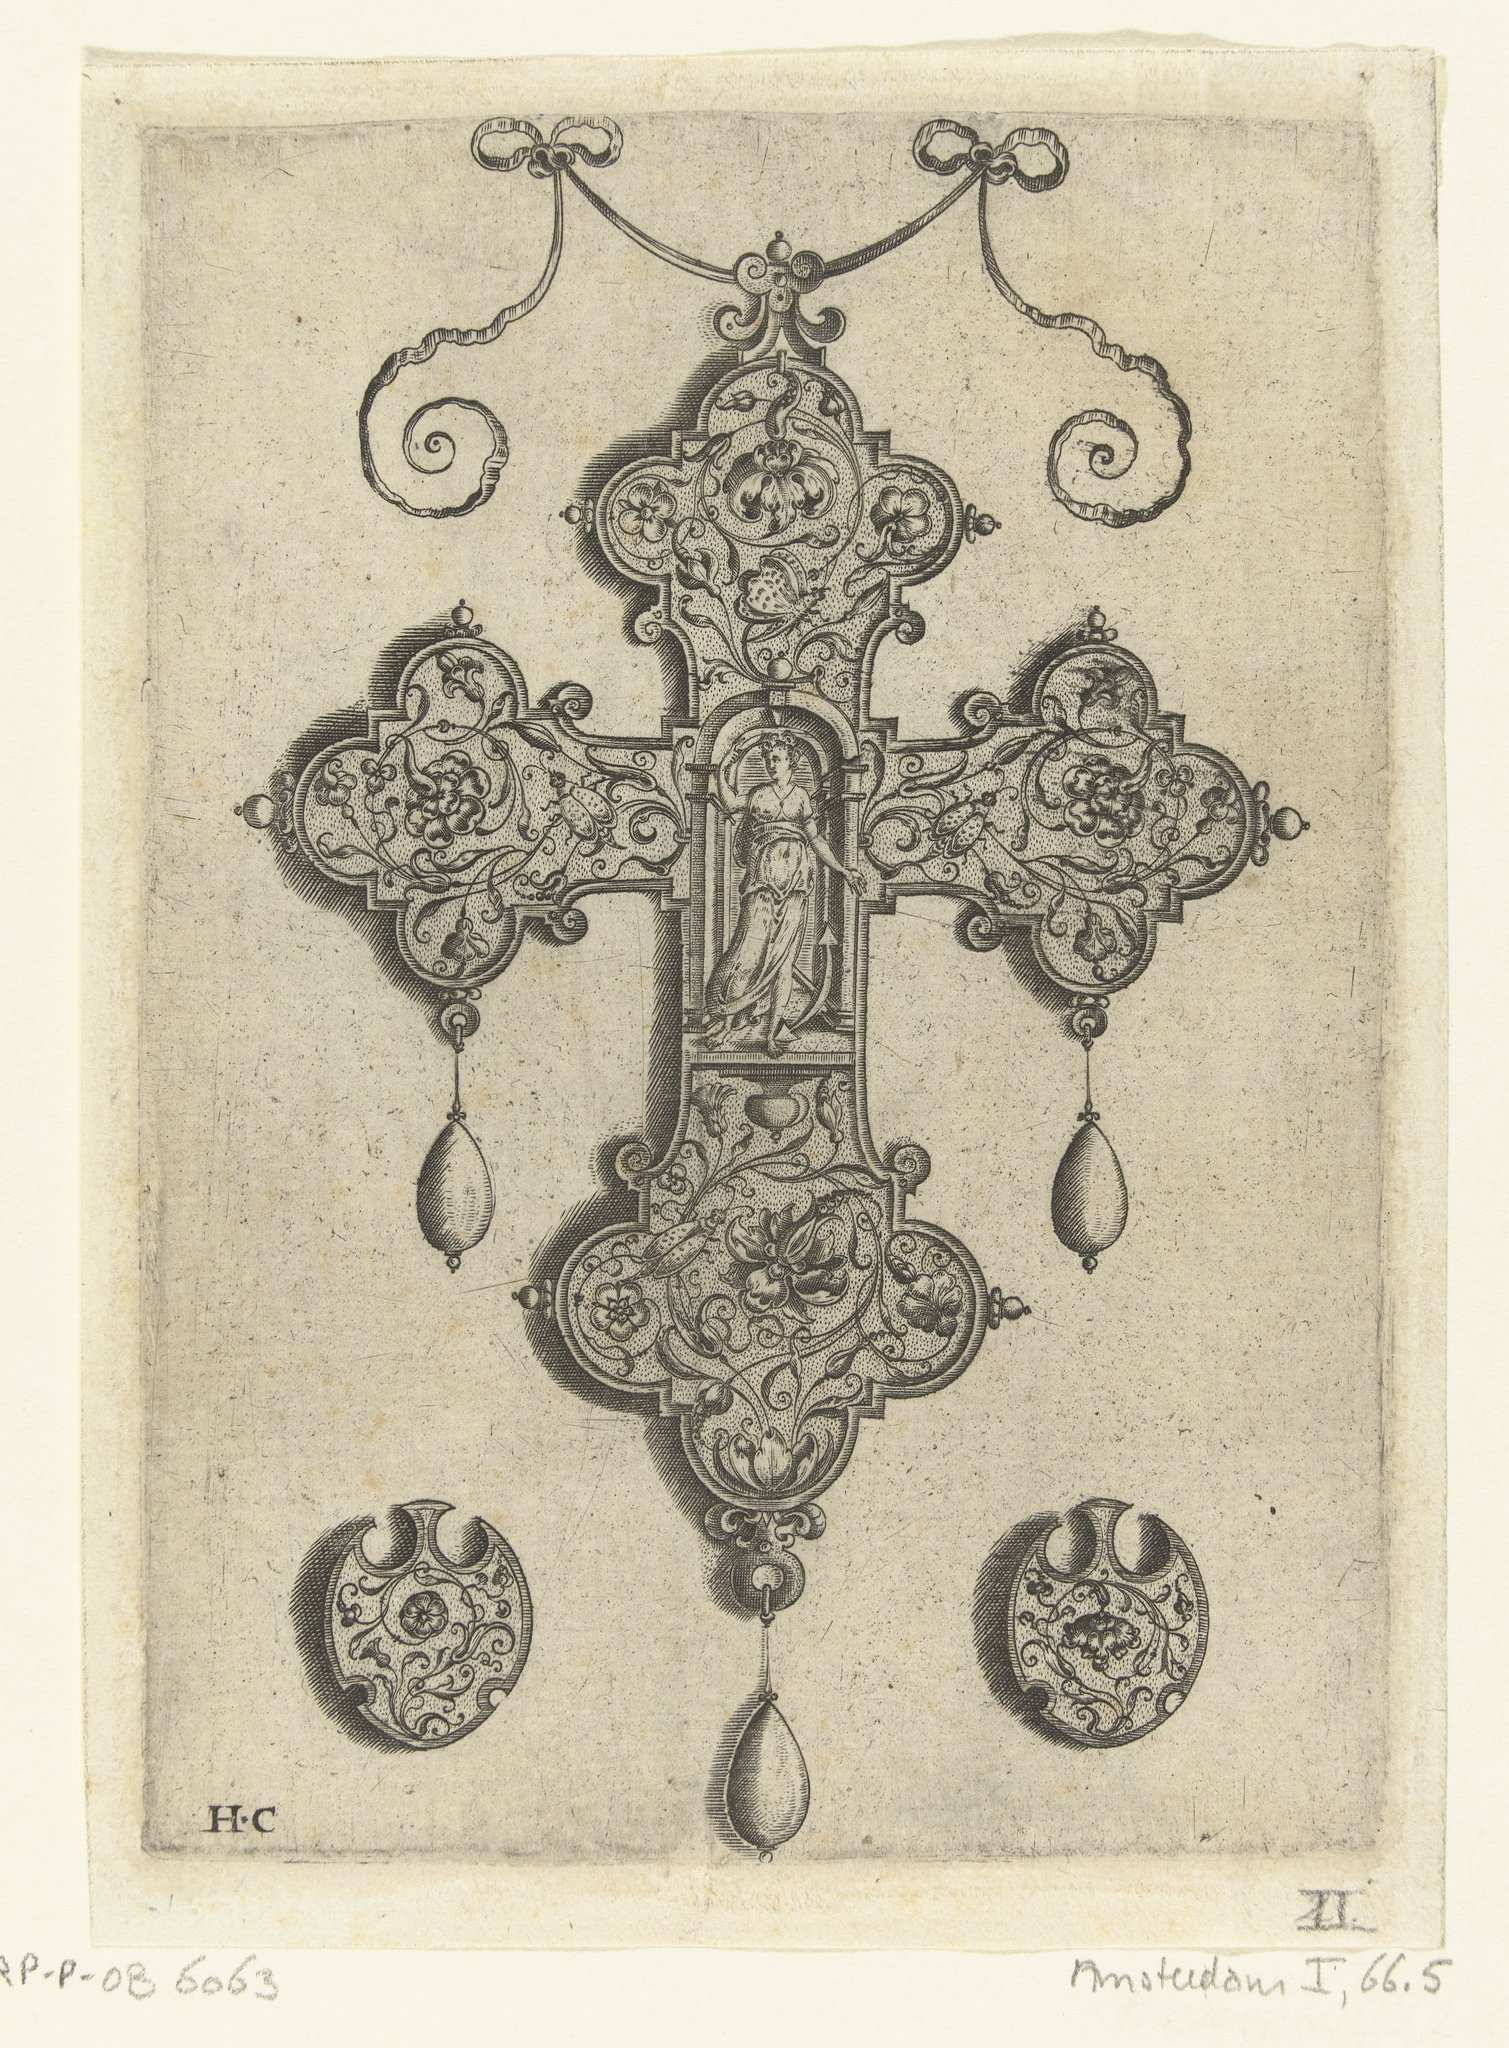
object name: print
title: Hangers met arabesken en figuren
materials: paper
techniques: engraving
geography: netherlands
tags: hope, 'spes'; 'speranza divina e certa' (ripa) ~ one of the three theological virtues, pendant, trinket, 'breloque'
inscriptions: monogram: ‘H.C.’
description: Voorzijde van een kruisvormige hanger. In het midden een halfronde nis waarin Spes met anker. Linksonder en rechtsonder een bijna rond kostuumornament. Een van 6 bladen afkomstig uit een serie van 10 bladen met hangers. Aan iedere hanger hangen drie parels. Op elk blad bovendien nog twee of vier kleine kostuumornamenten.